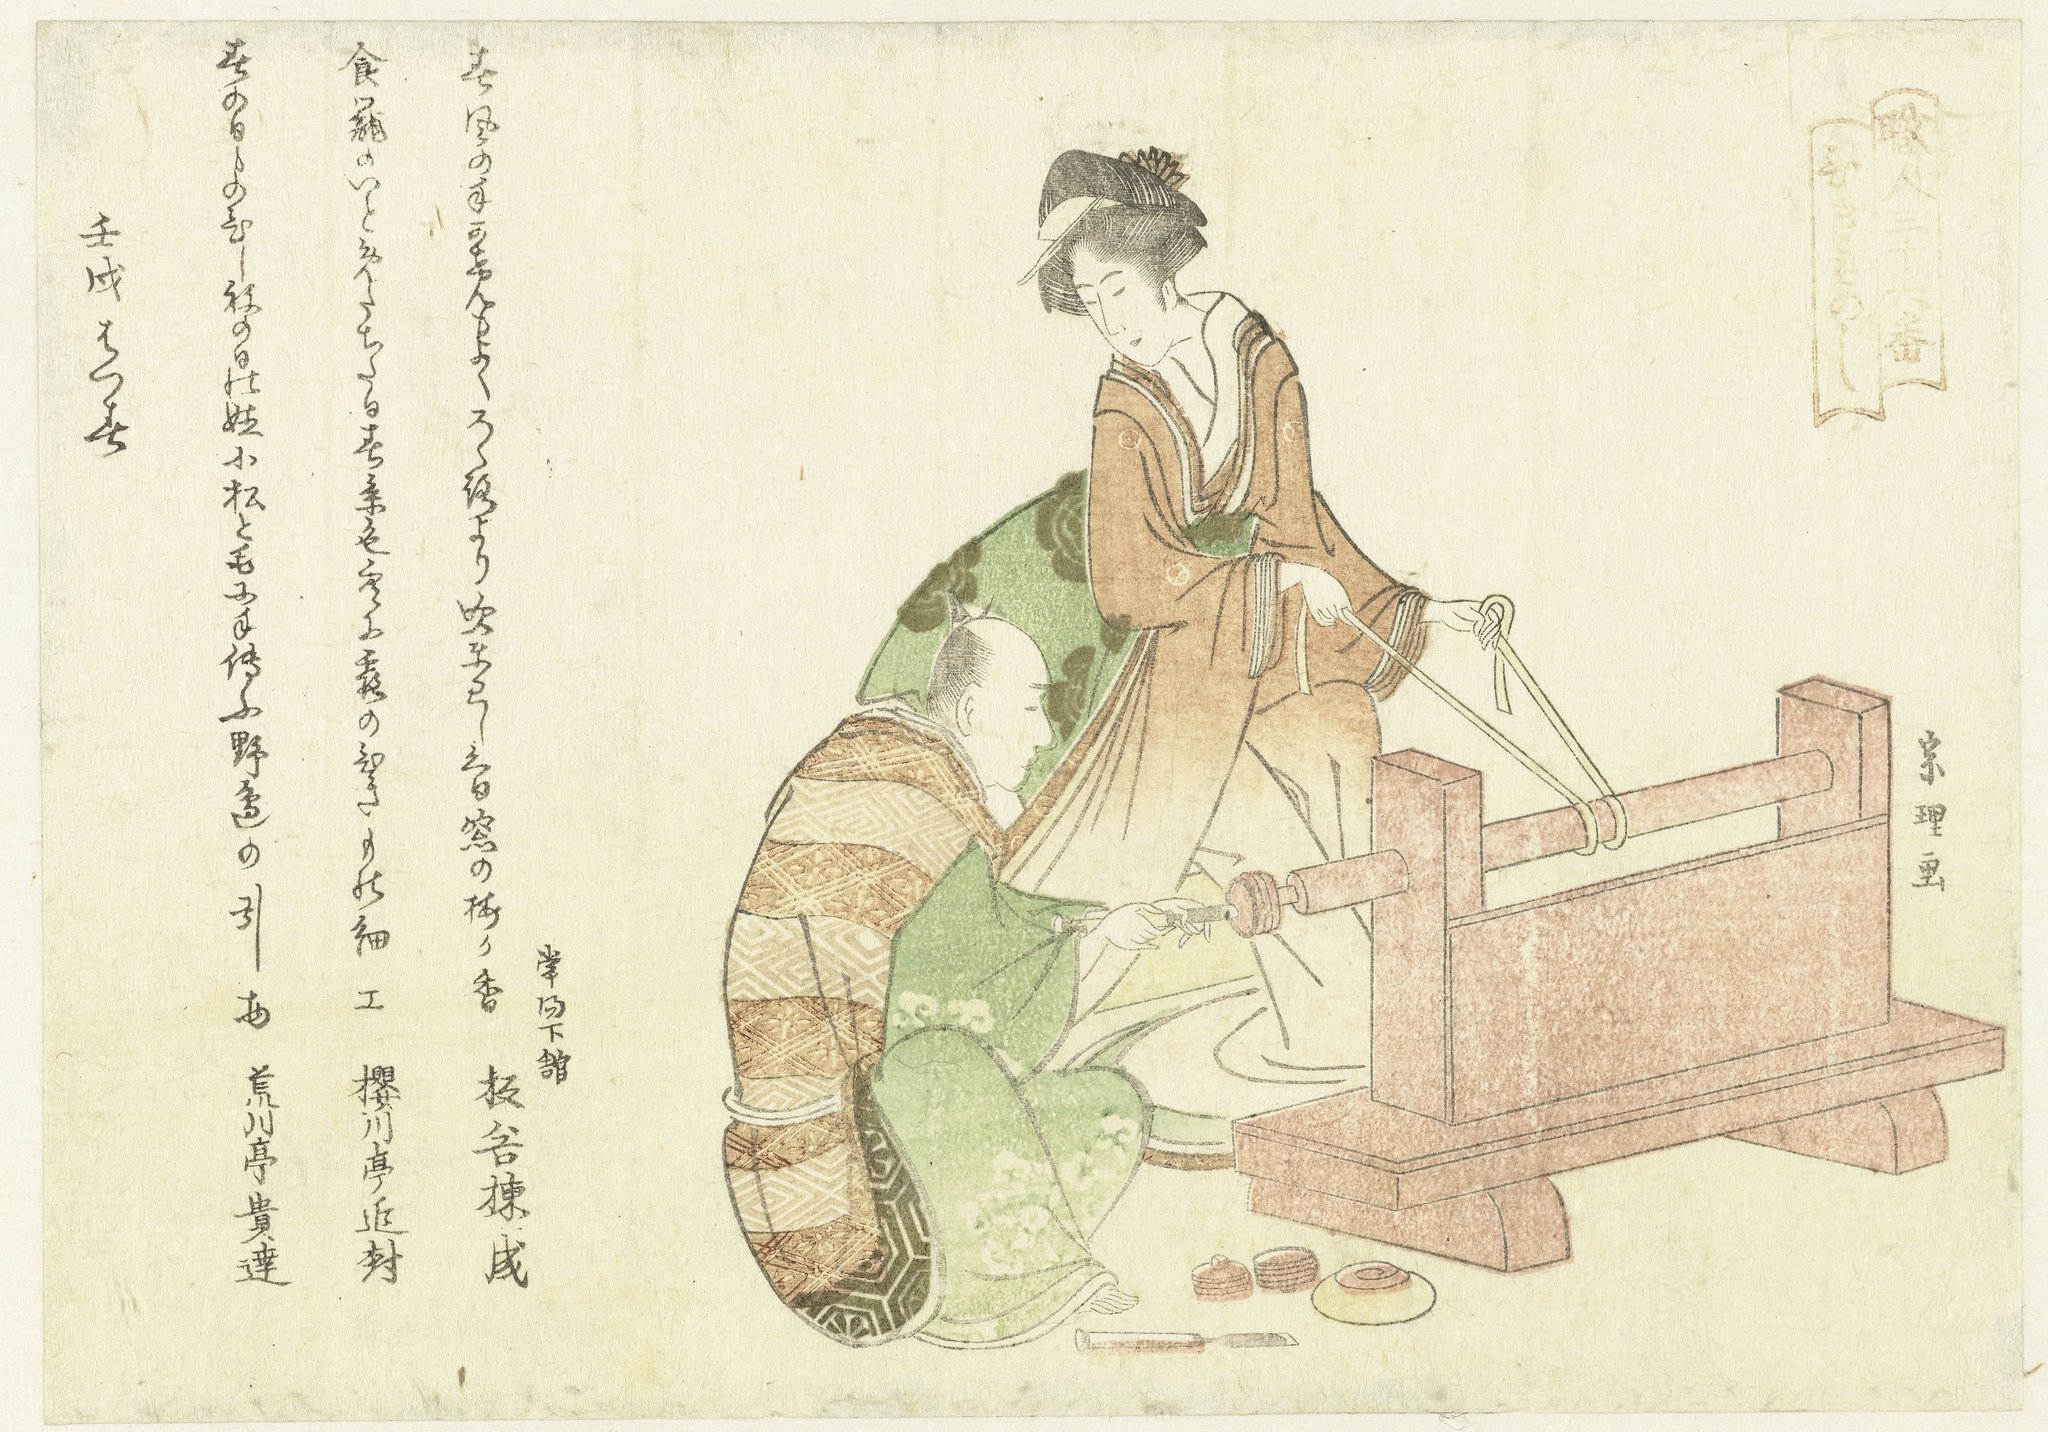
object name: print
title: A Turner and His Assistant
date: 1802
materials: paper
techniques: blind stamped, woodcut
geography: japan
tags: handicrafts, craftsman at work, machines; parts of machines; tools and appliances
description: Een surimono is een luxe uitgevoerde prent waarop beeld met één of meerdere gedichten gecombineerd is. Bij het drukken van een surimono werd vaak gebruik gemaakt van dikker papier, blinddruk en metaal pigmenten, zoals koper- en zilverpoeder. De prenten werden vaak in opdracht van dichters gemaakt en als exclusief geschenk aan vrienden en relaties gegeven.